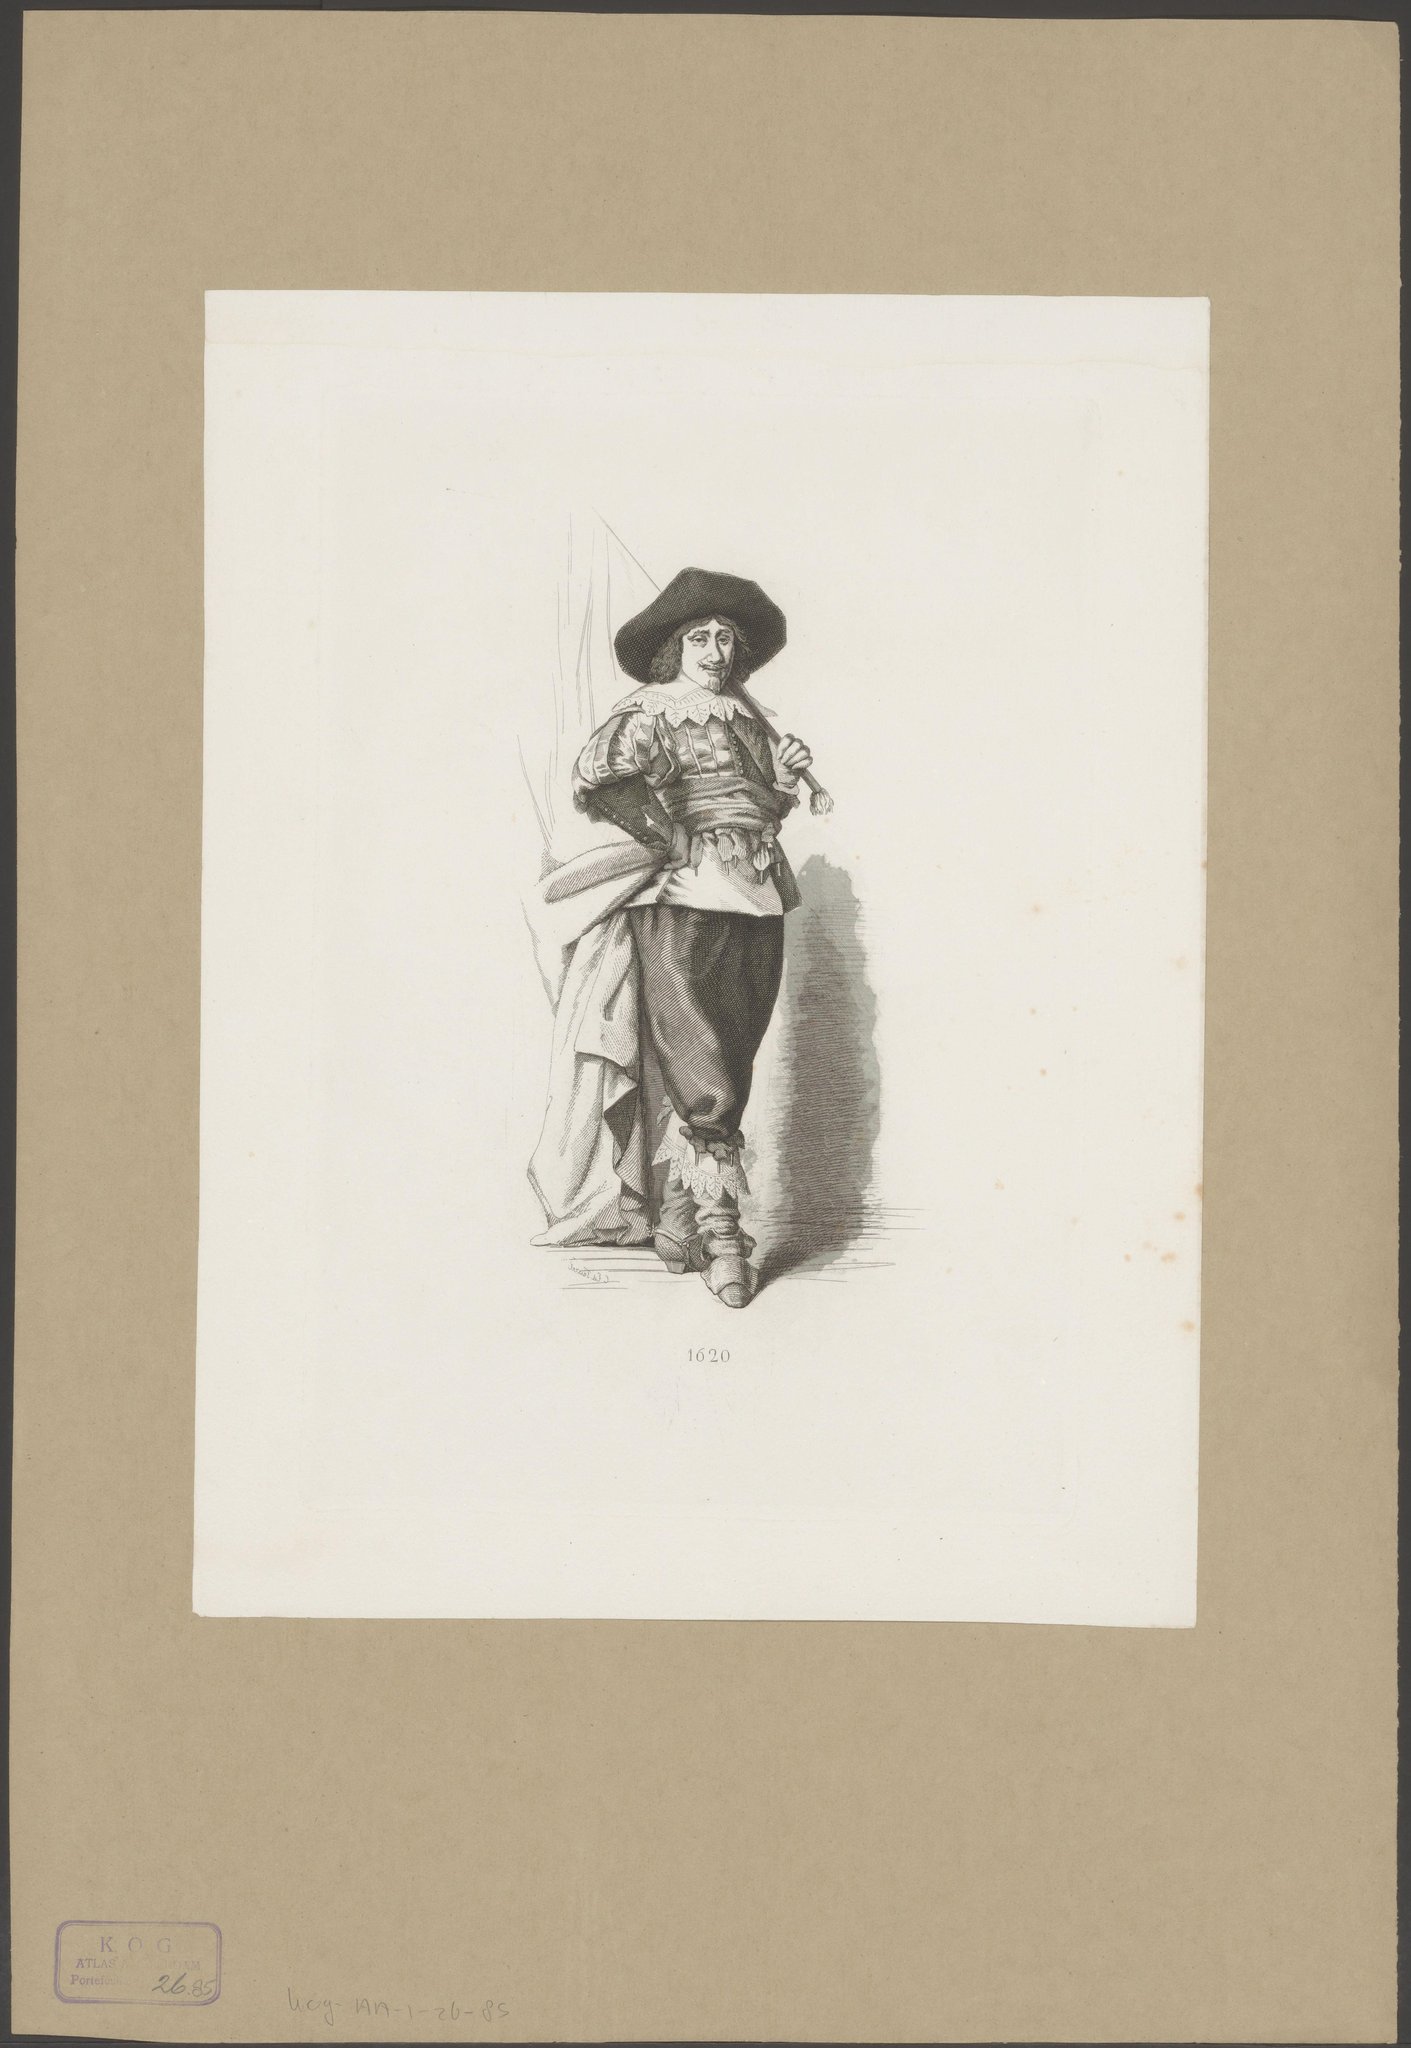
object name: book illustration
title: 1620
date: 1874-1875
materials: paper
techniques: engraving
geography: amsterdam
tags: amsterdam, historical persons, (military) standard-bearer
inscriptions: collector's mark: Lugt 1641b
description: Prent mogelijk uit: Hofdijk, Willem Jacobsz. De oude schutterij in Nederland. Amsterdam: Reinier Willem Petrus de Vries, 1874. Of uit: Hofdijk, Willem Jacobsz. De oude schutterij in Nederland. Utrecht: Kemink & Zoon, 1875.